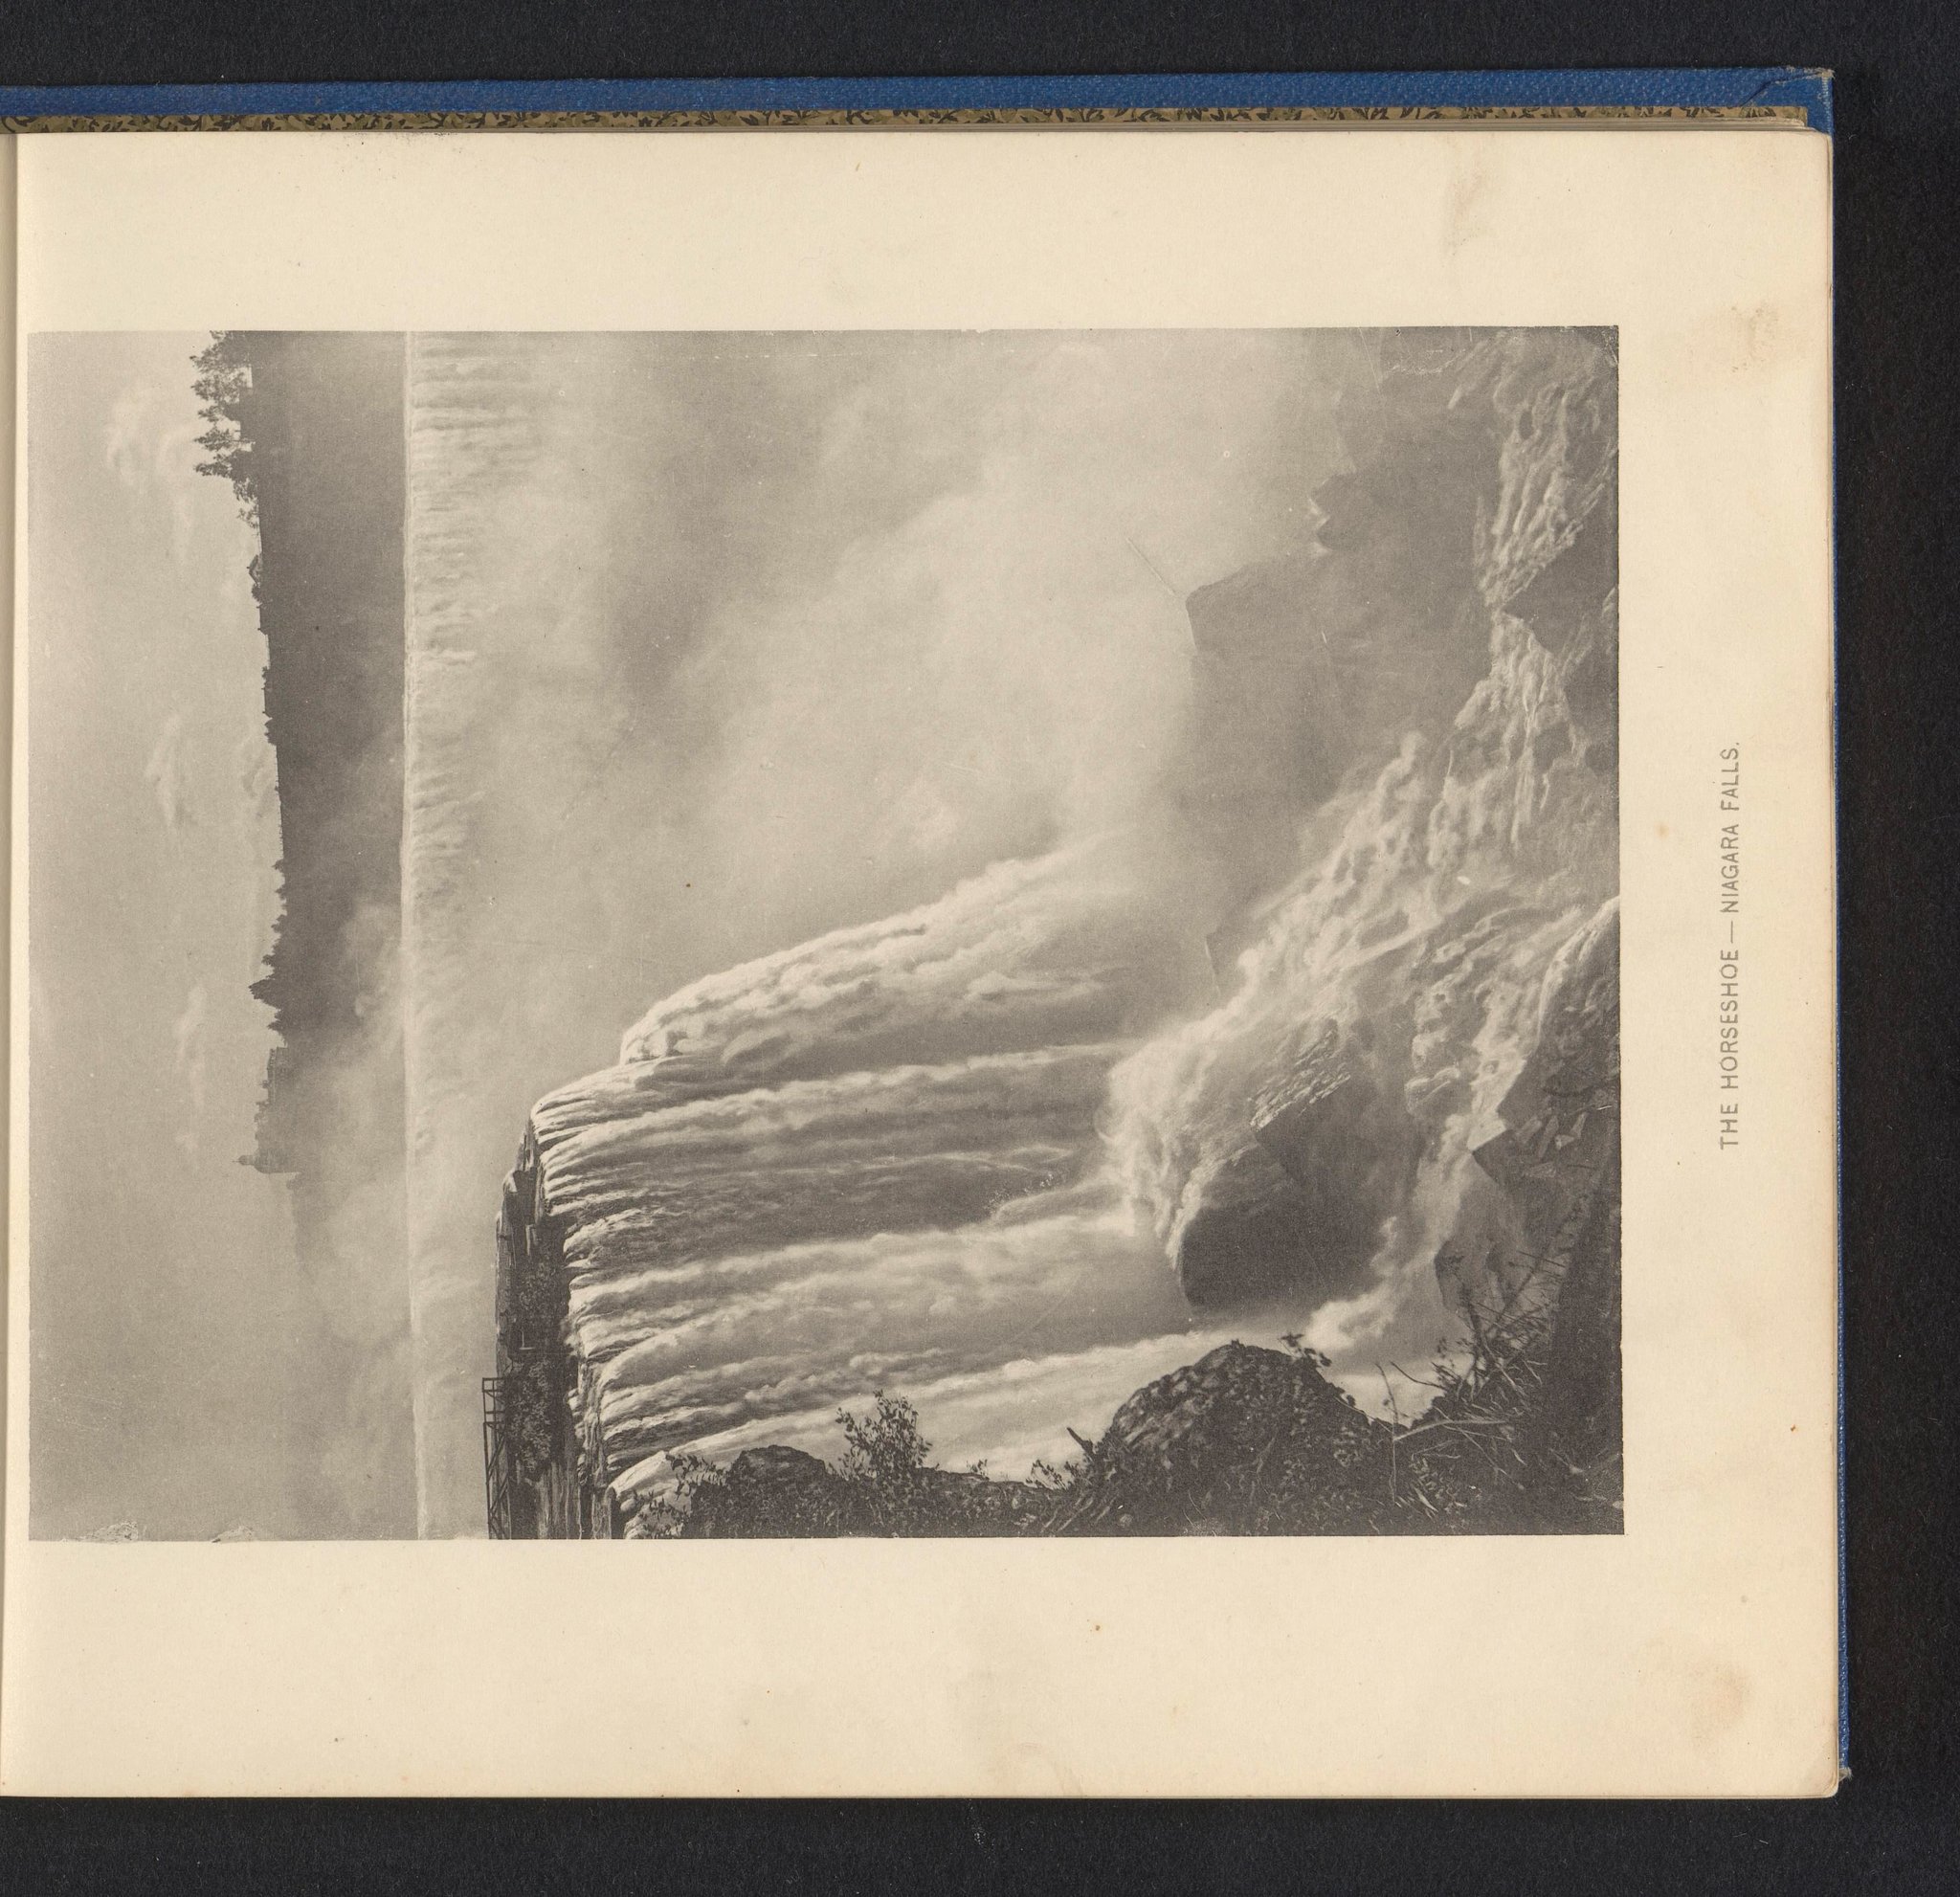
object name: photomechanical print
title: Gezicht op de Horseshoe Falls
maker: Anonymous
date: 1883-1893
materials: paper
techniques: photograph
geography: new york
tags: waterfall